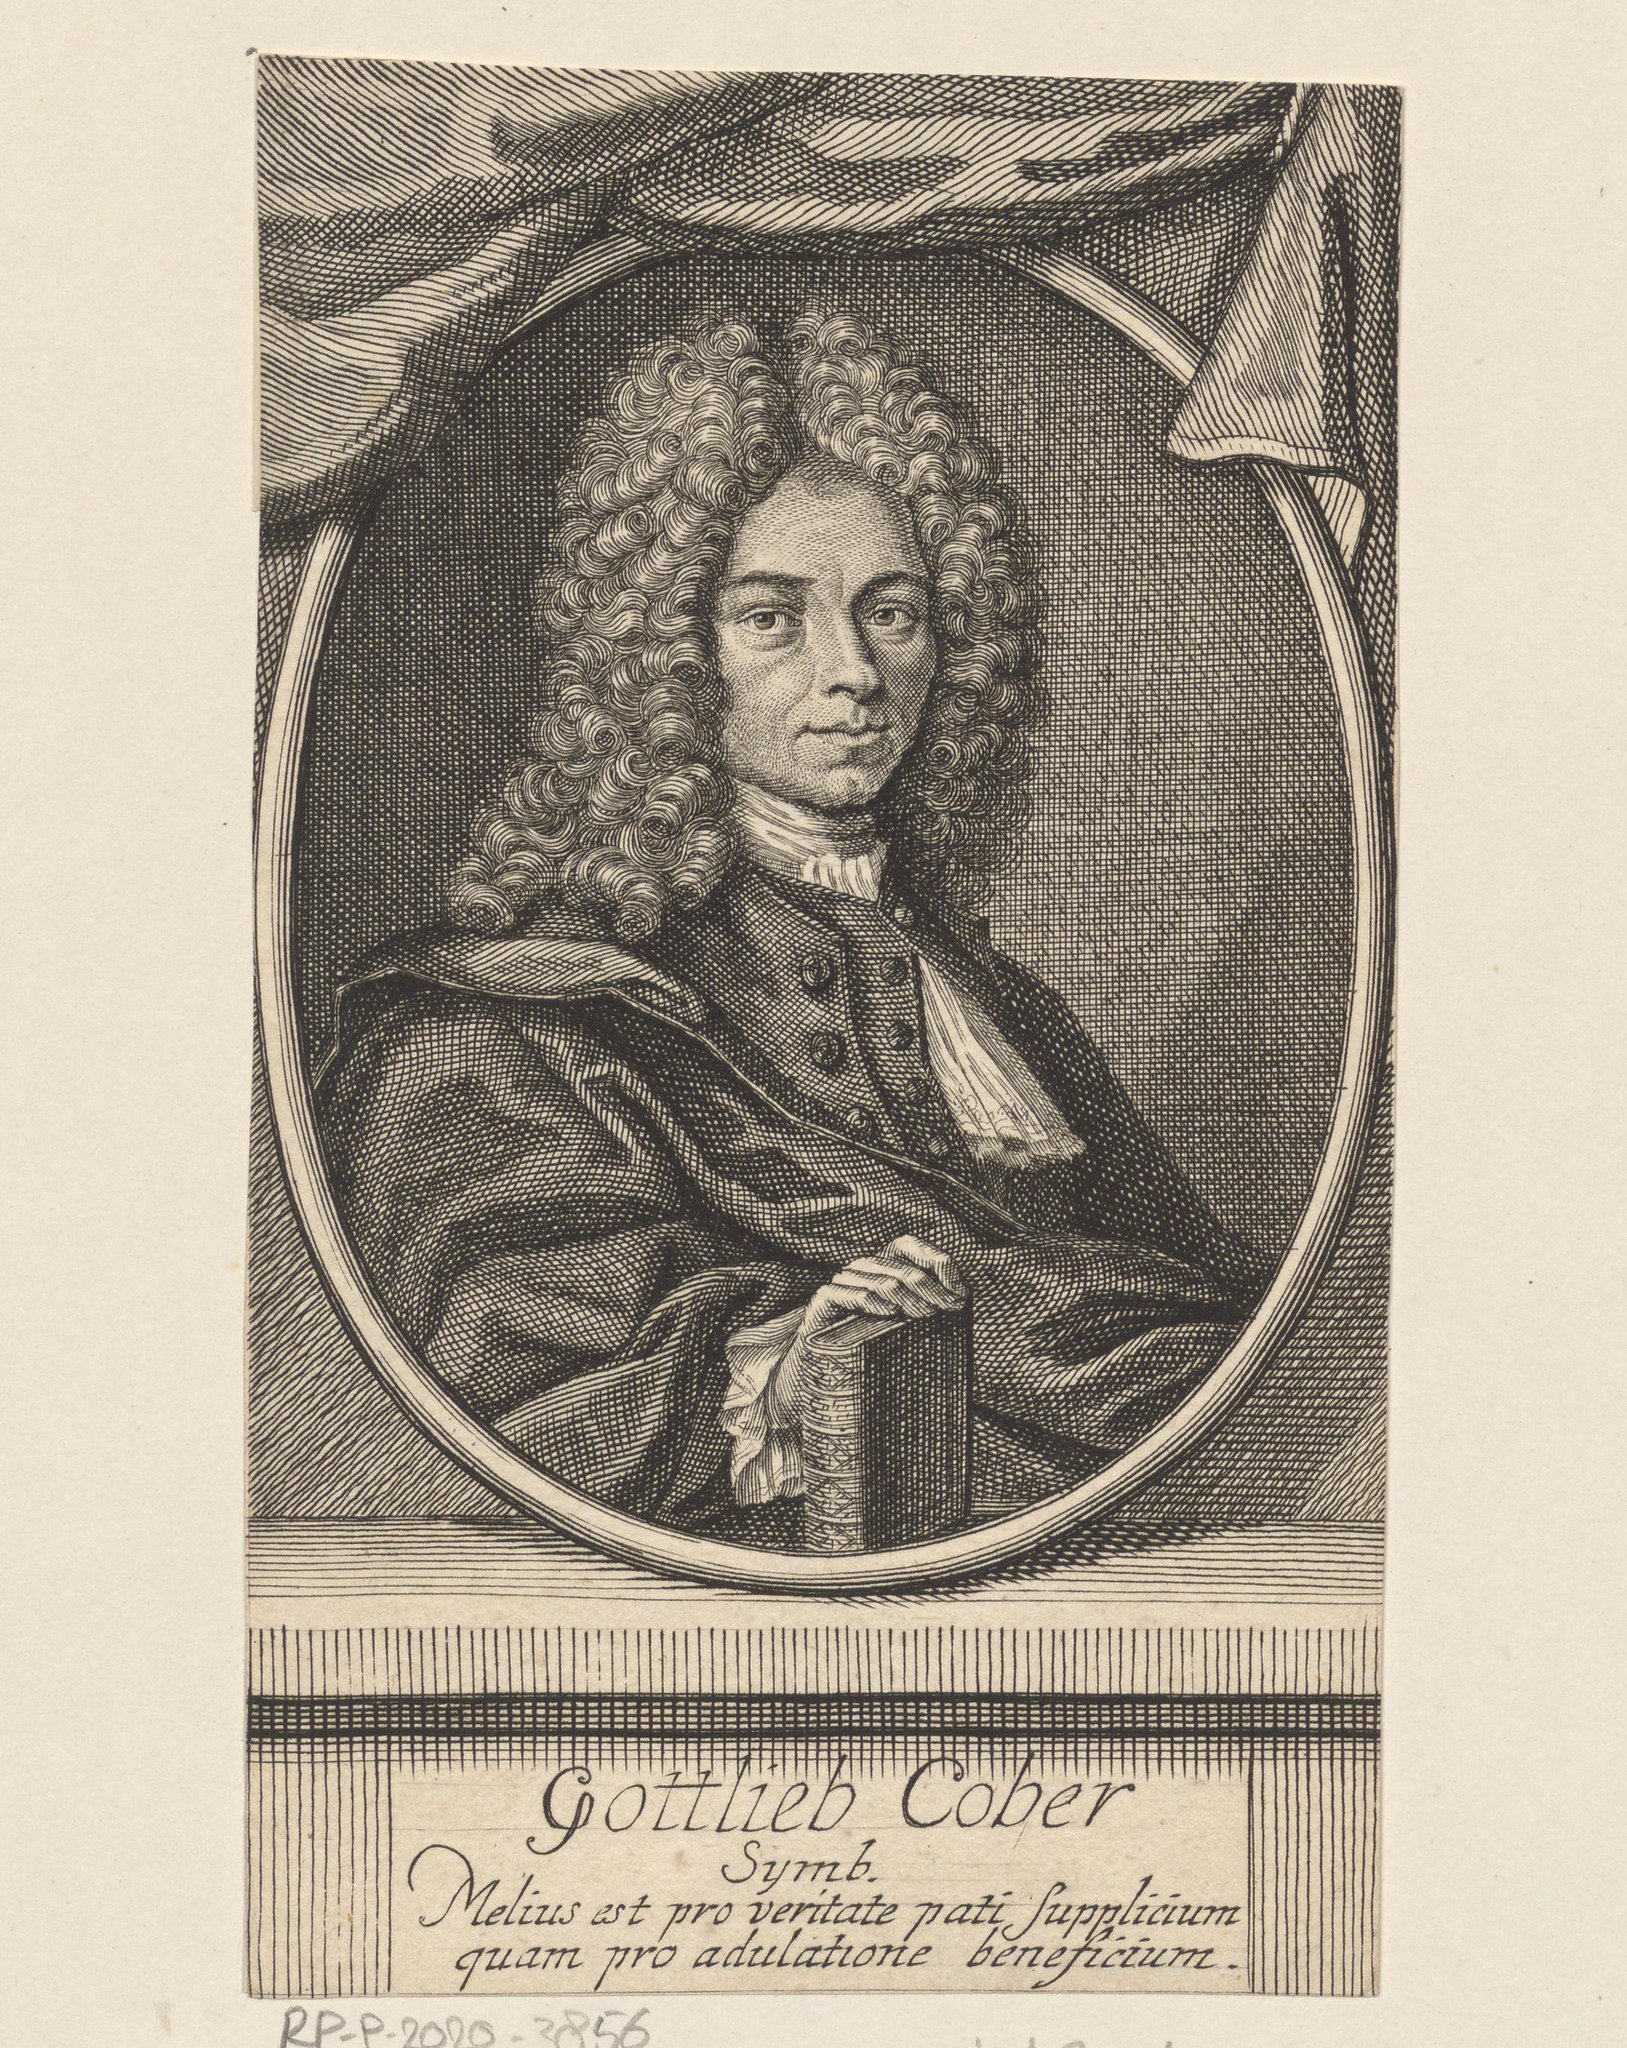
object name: print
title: Portret van Gottlieb Cober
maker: johann georg mentzel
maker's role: print maker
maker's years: 1677-1743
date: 1702-1743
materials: paper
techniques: engraving, etching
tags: historical persons